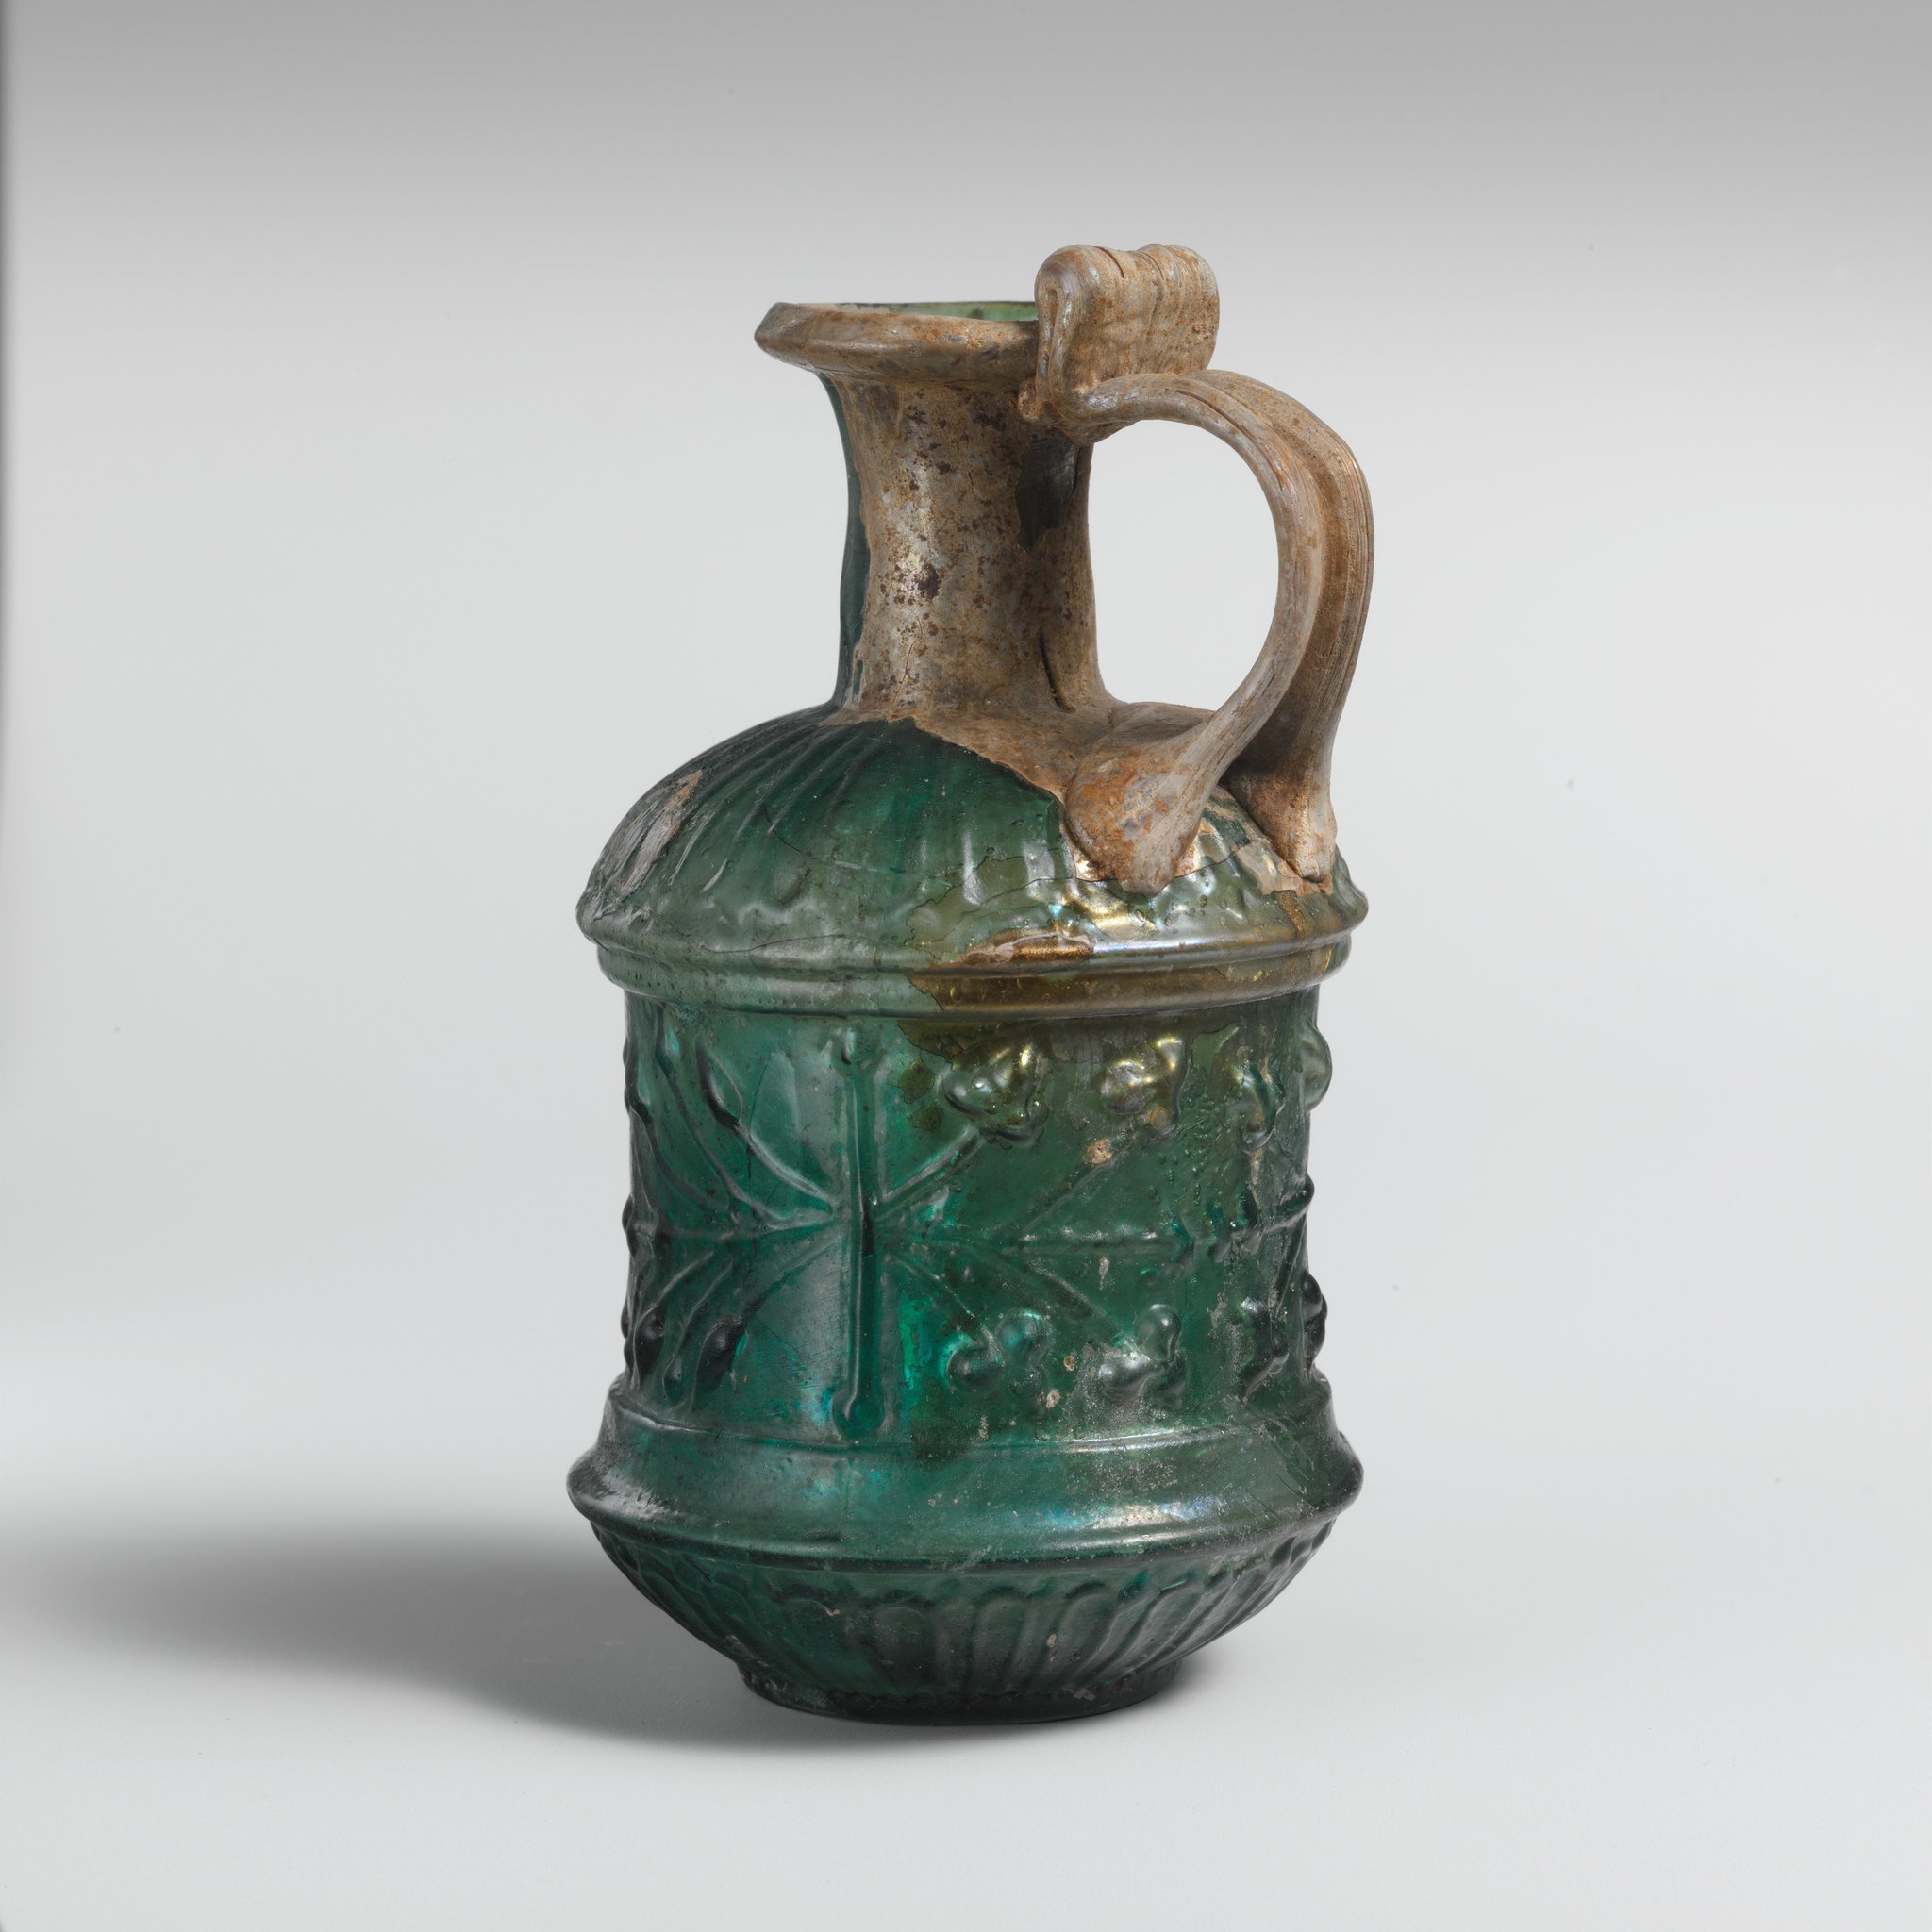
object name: jug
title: Glass jug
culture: roman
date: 1-50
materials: glass